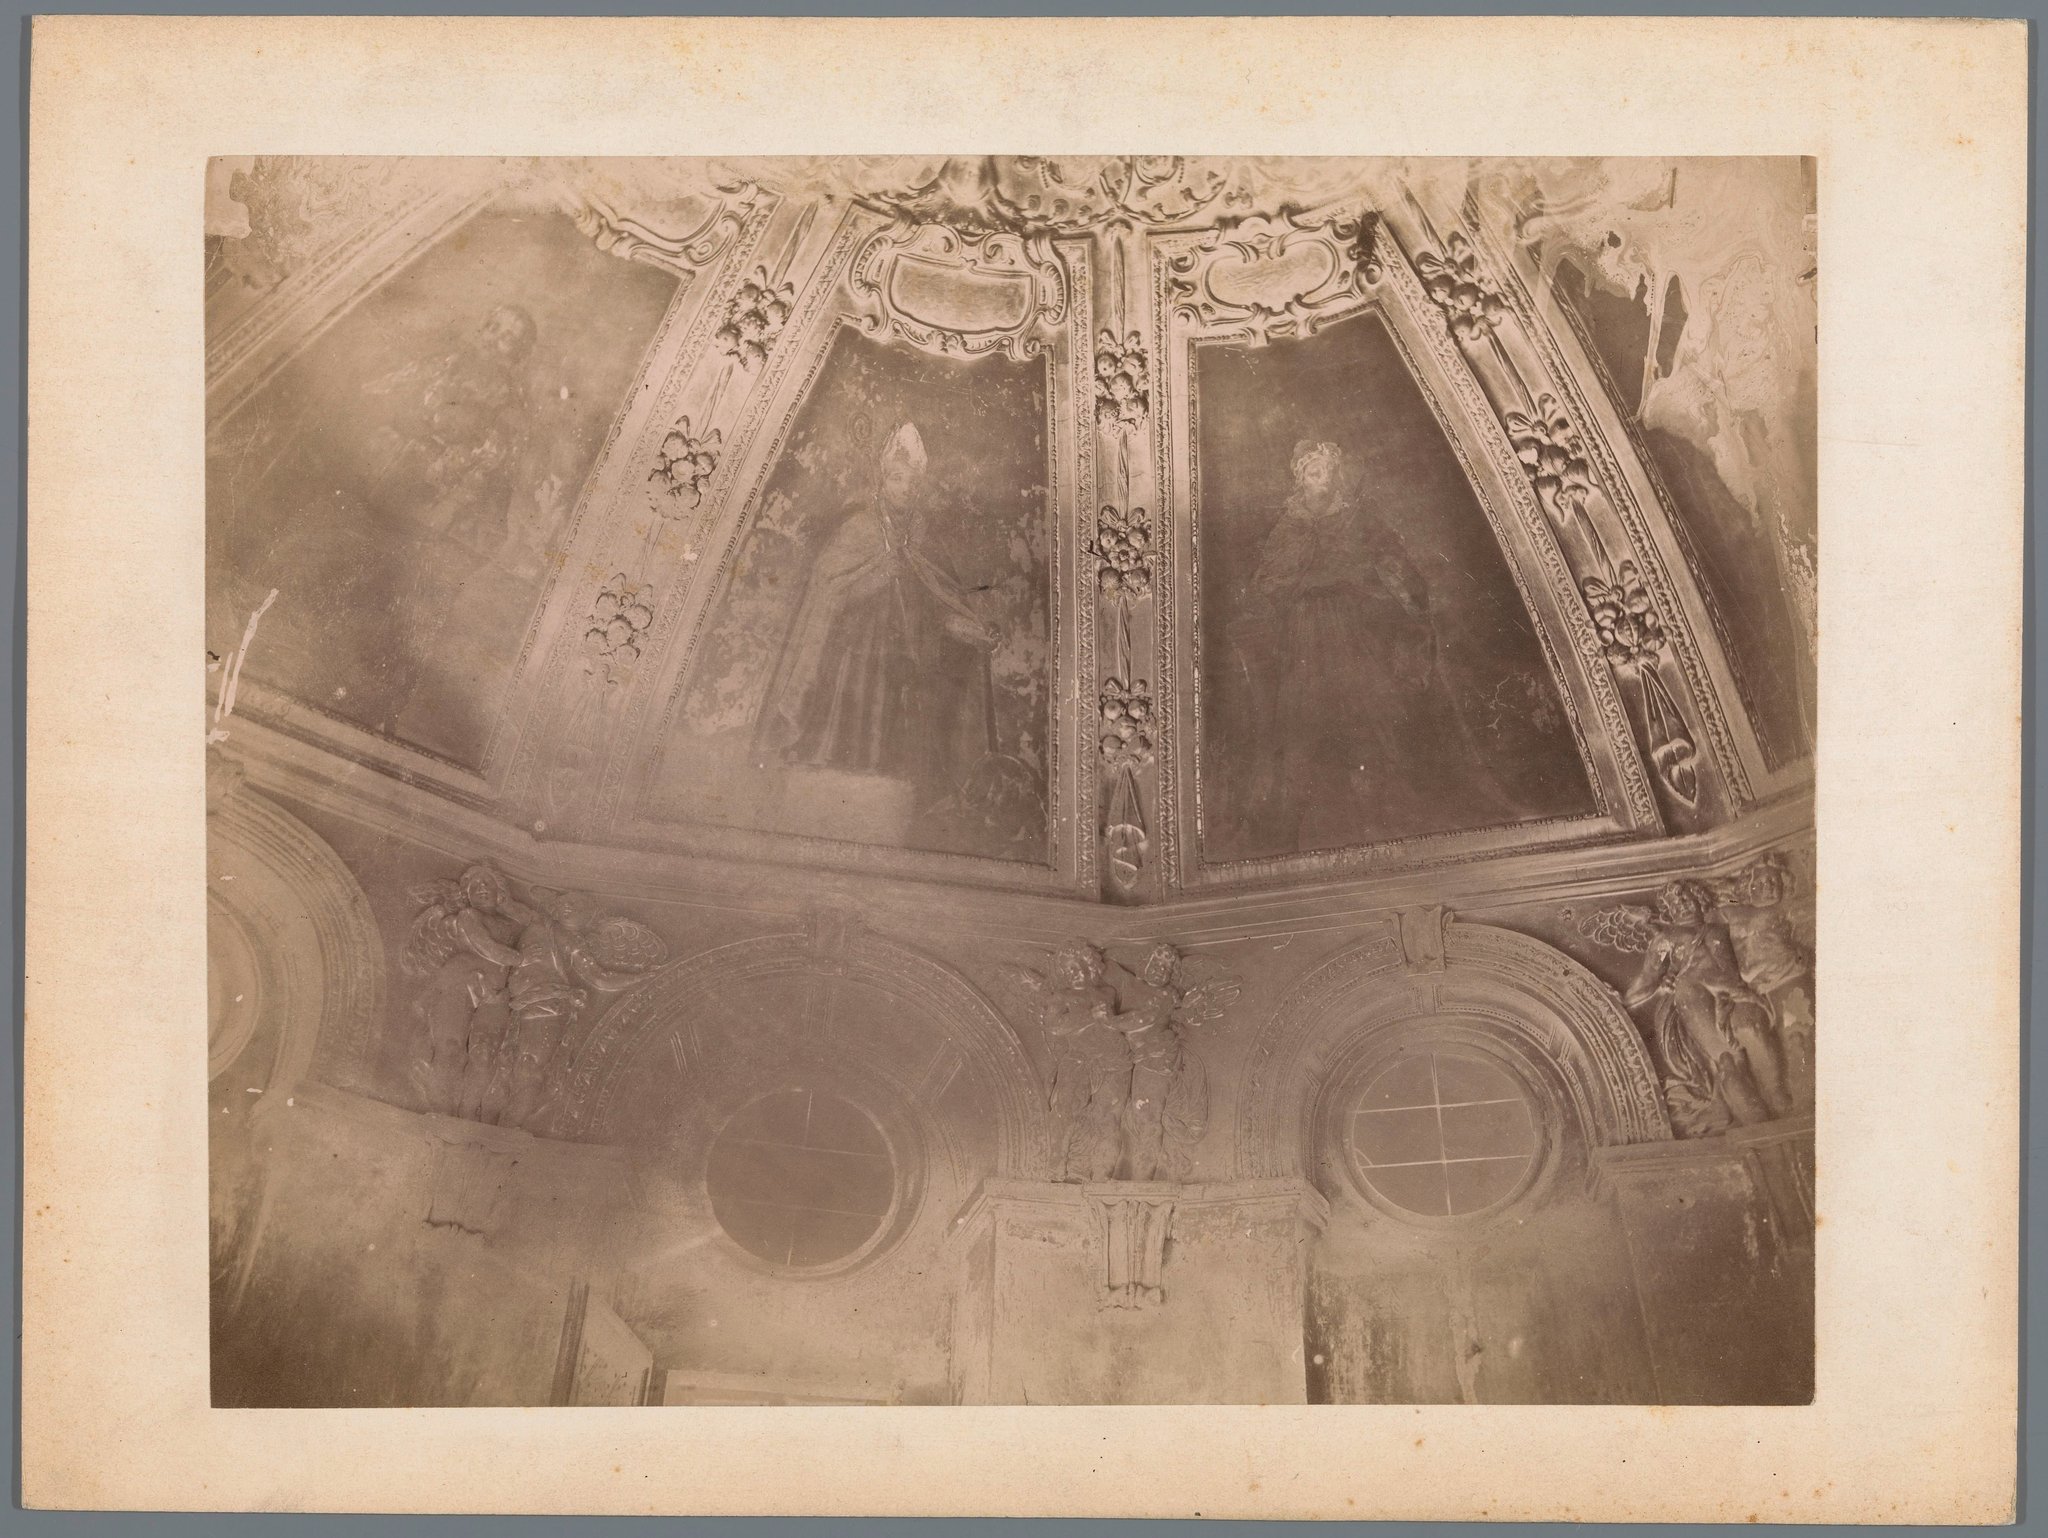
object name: photograph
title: Plafond van vermoedelijk een kerk met schilderingen van christelijke figuren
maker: Anonymous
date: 1875-1900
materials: cardboard, photographic support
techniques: albumen print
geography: europe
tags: saints, interior of church, (decorated) ceiling, europe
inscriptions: collector's mark: Lugt 3937